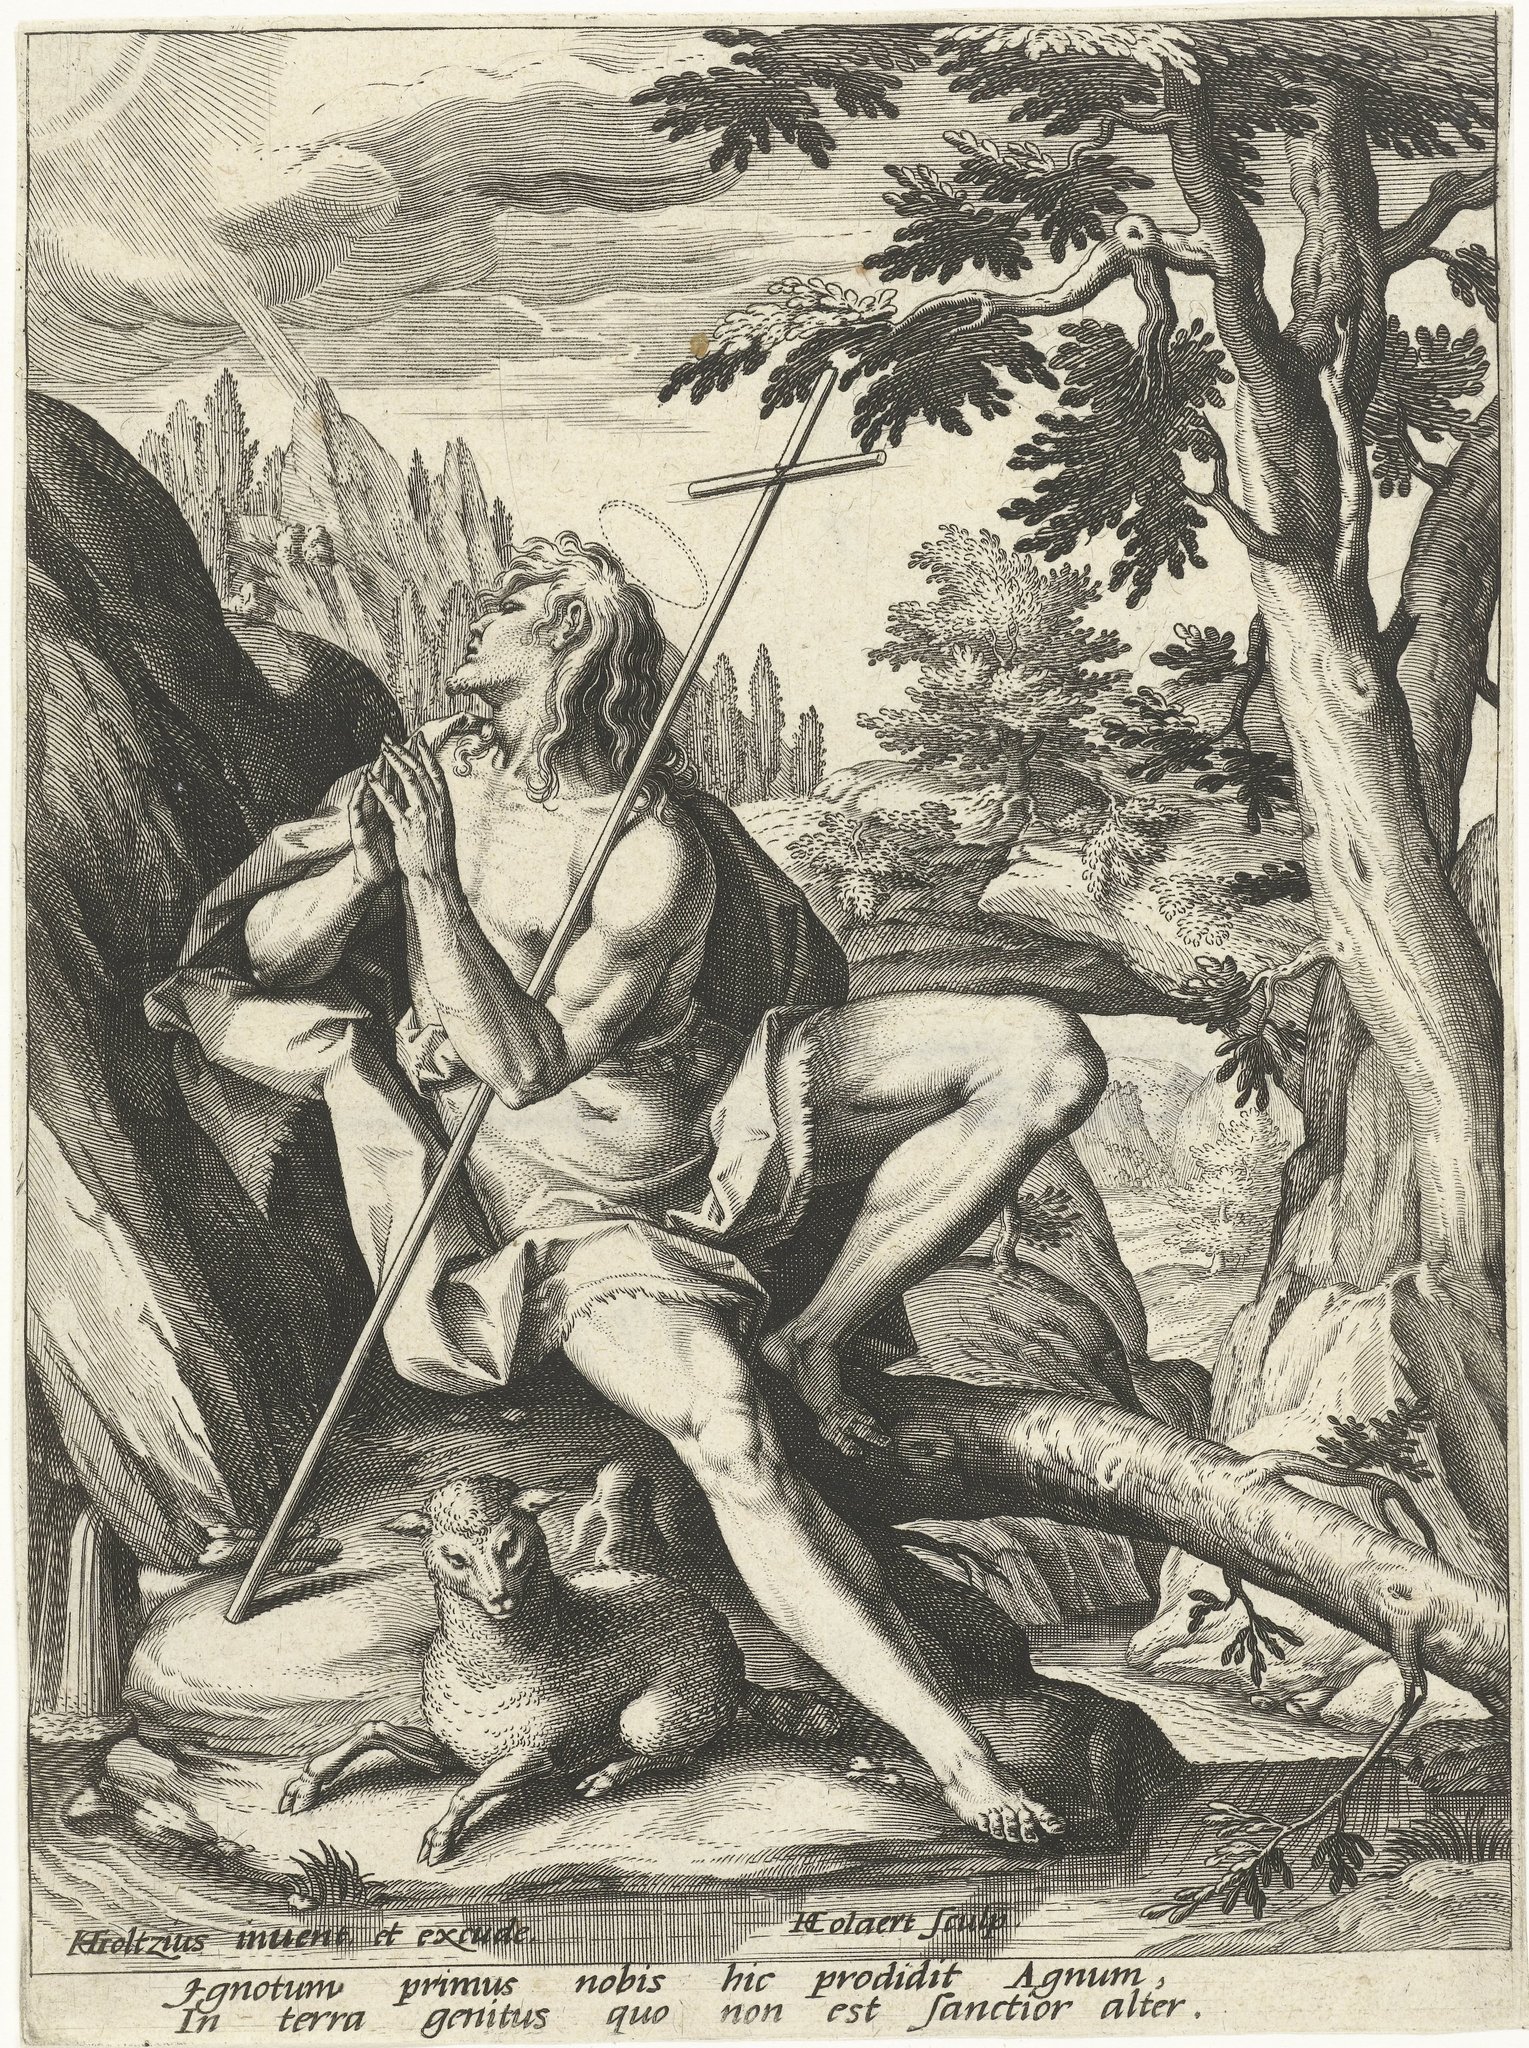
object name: print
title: Johannes de Doper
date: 1570-1618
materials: paper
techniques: engraving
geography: haarlem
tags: john the baptist; possible attributes: book, reed cross, baptismal cup, honeycomb, lamb, staff - specific aspects ~ male saint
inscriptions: collector's mark: Lugt 2228, inscription: ‘genaald tegen een exemple waarvan het ondermarge afgesneden.’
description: Johannes de Doper zit tegen een rots. Op de achtergrond een berglandschap. Een lammetje ligt naast hem langs een rivierstroompje. De prent heeft een Latijns onderschrift.